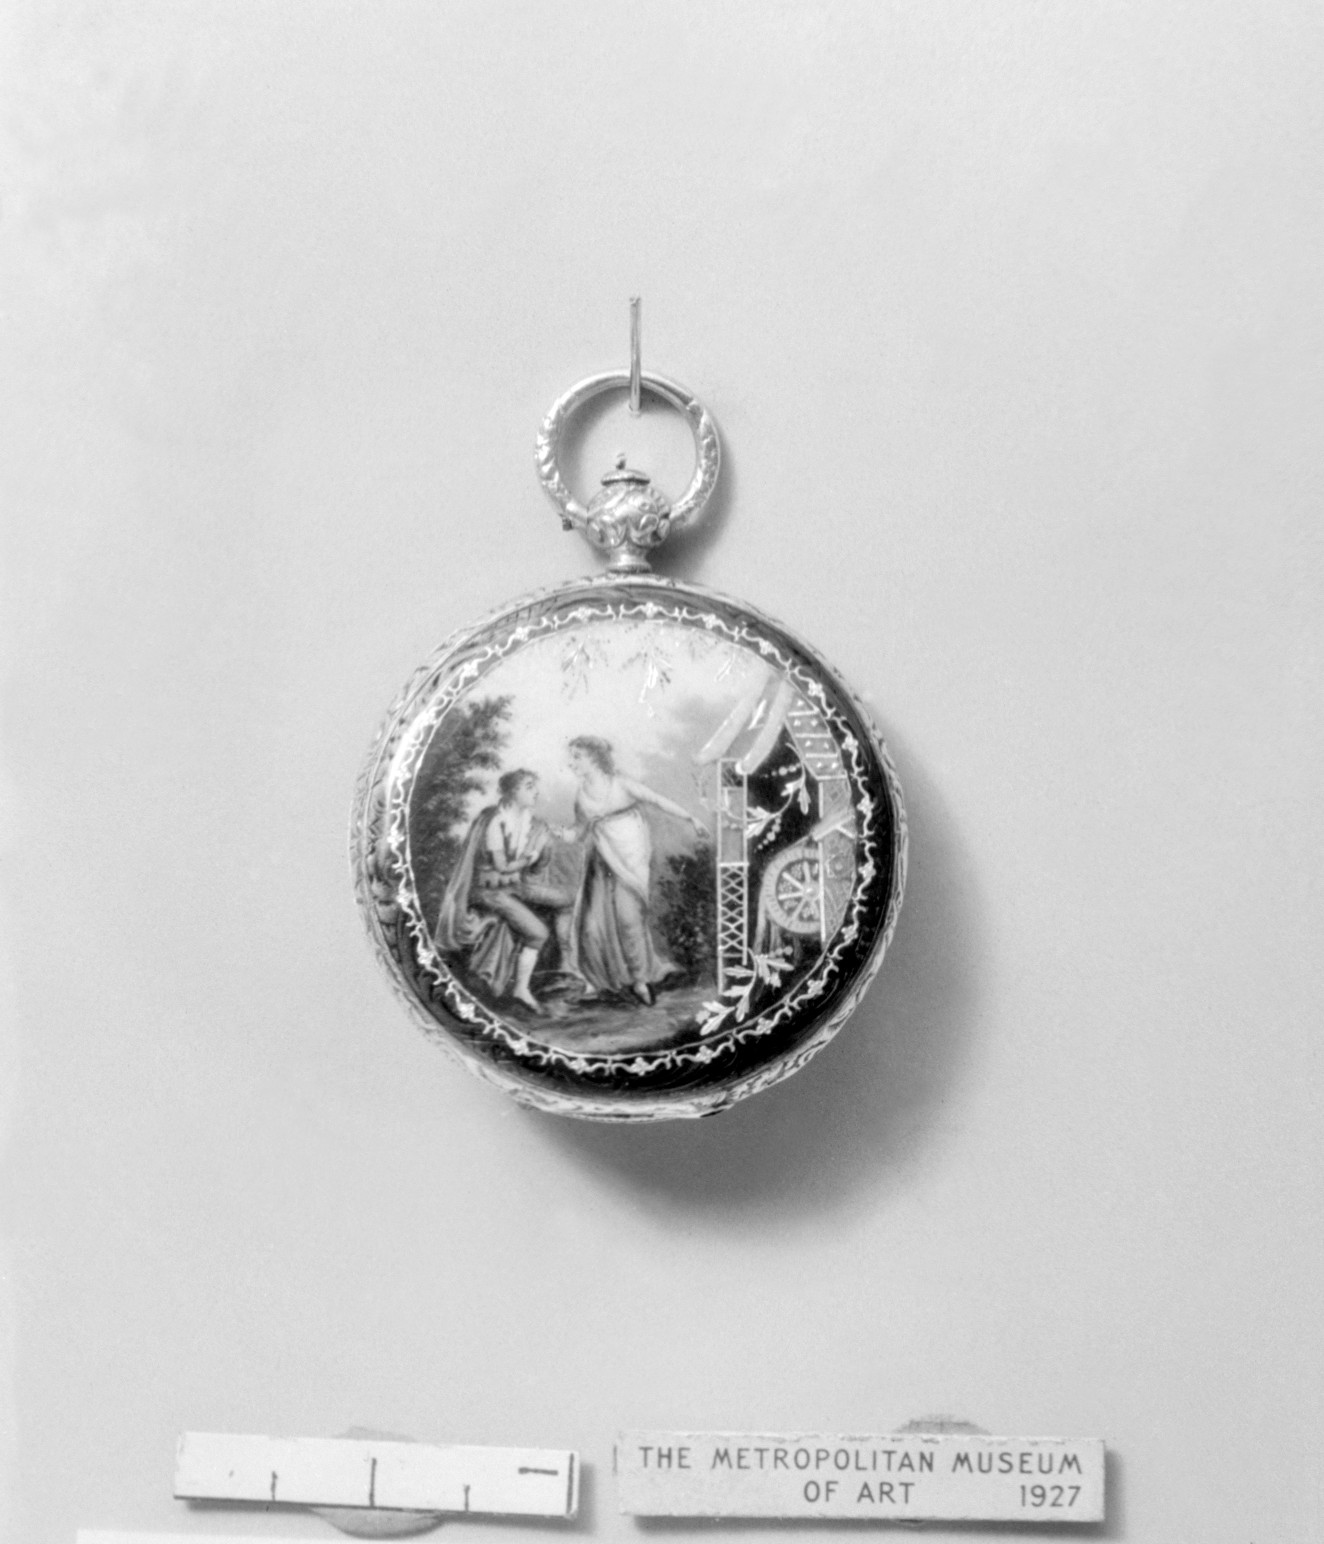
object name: watch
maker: firm of a. meynadier et cie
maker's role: maker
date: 1825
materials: enamel, gold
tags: men,women